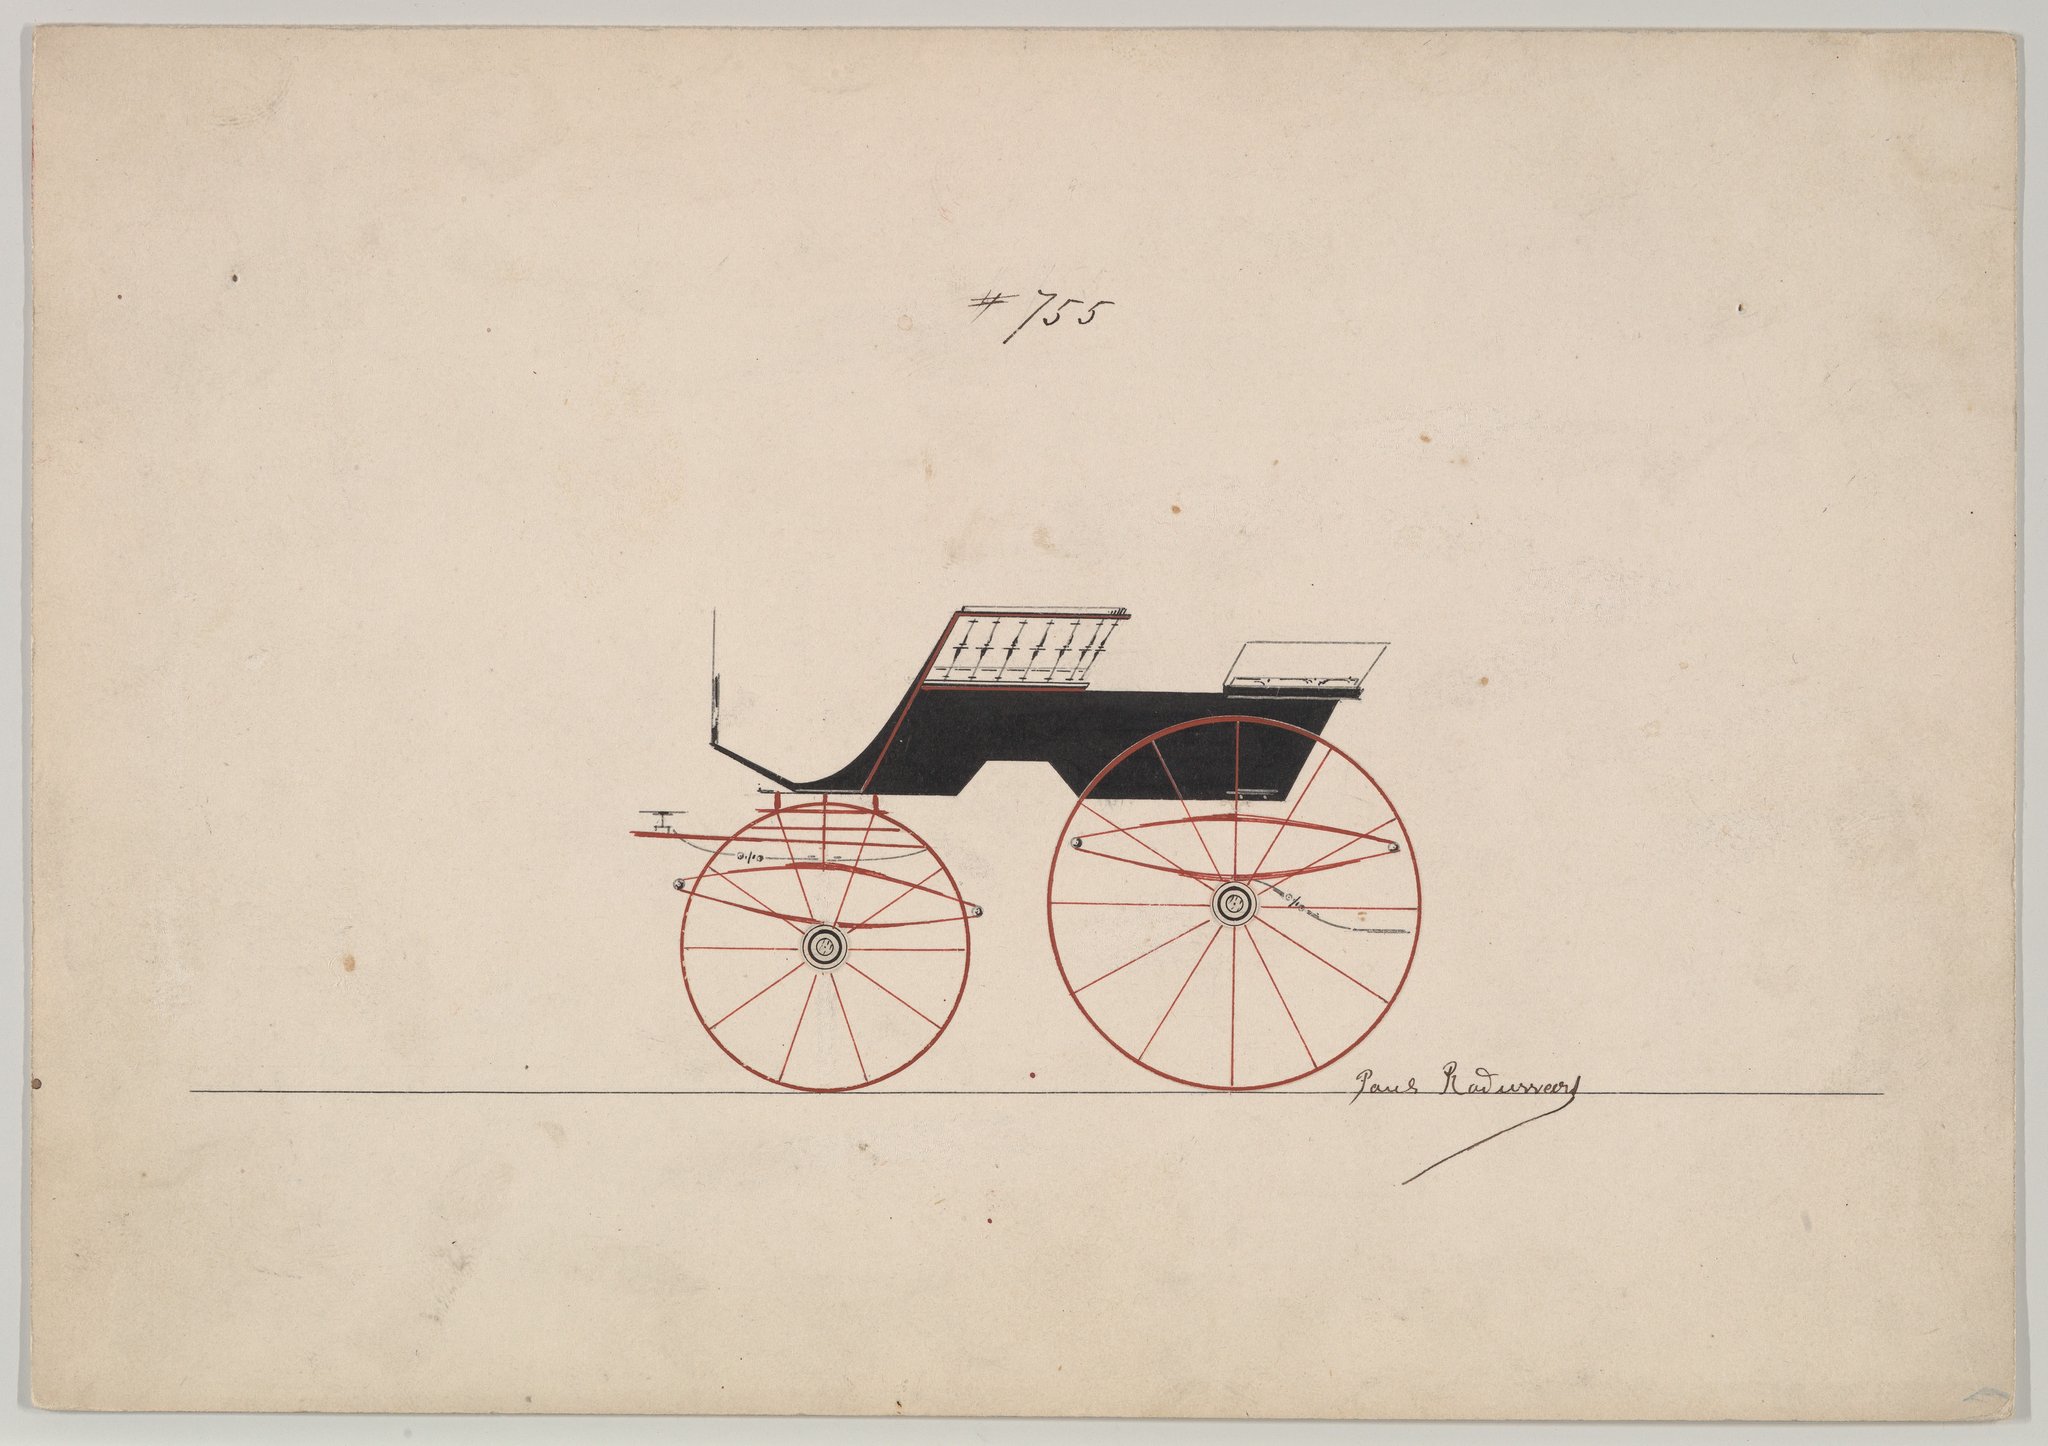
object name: drawing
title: T-Cart (Phaeton) #755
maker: brewster & co.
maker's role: manufacturer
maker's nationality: american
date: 1850-1870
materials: gouache, ink, watercolor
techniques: pen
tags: carriages